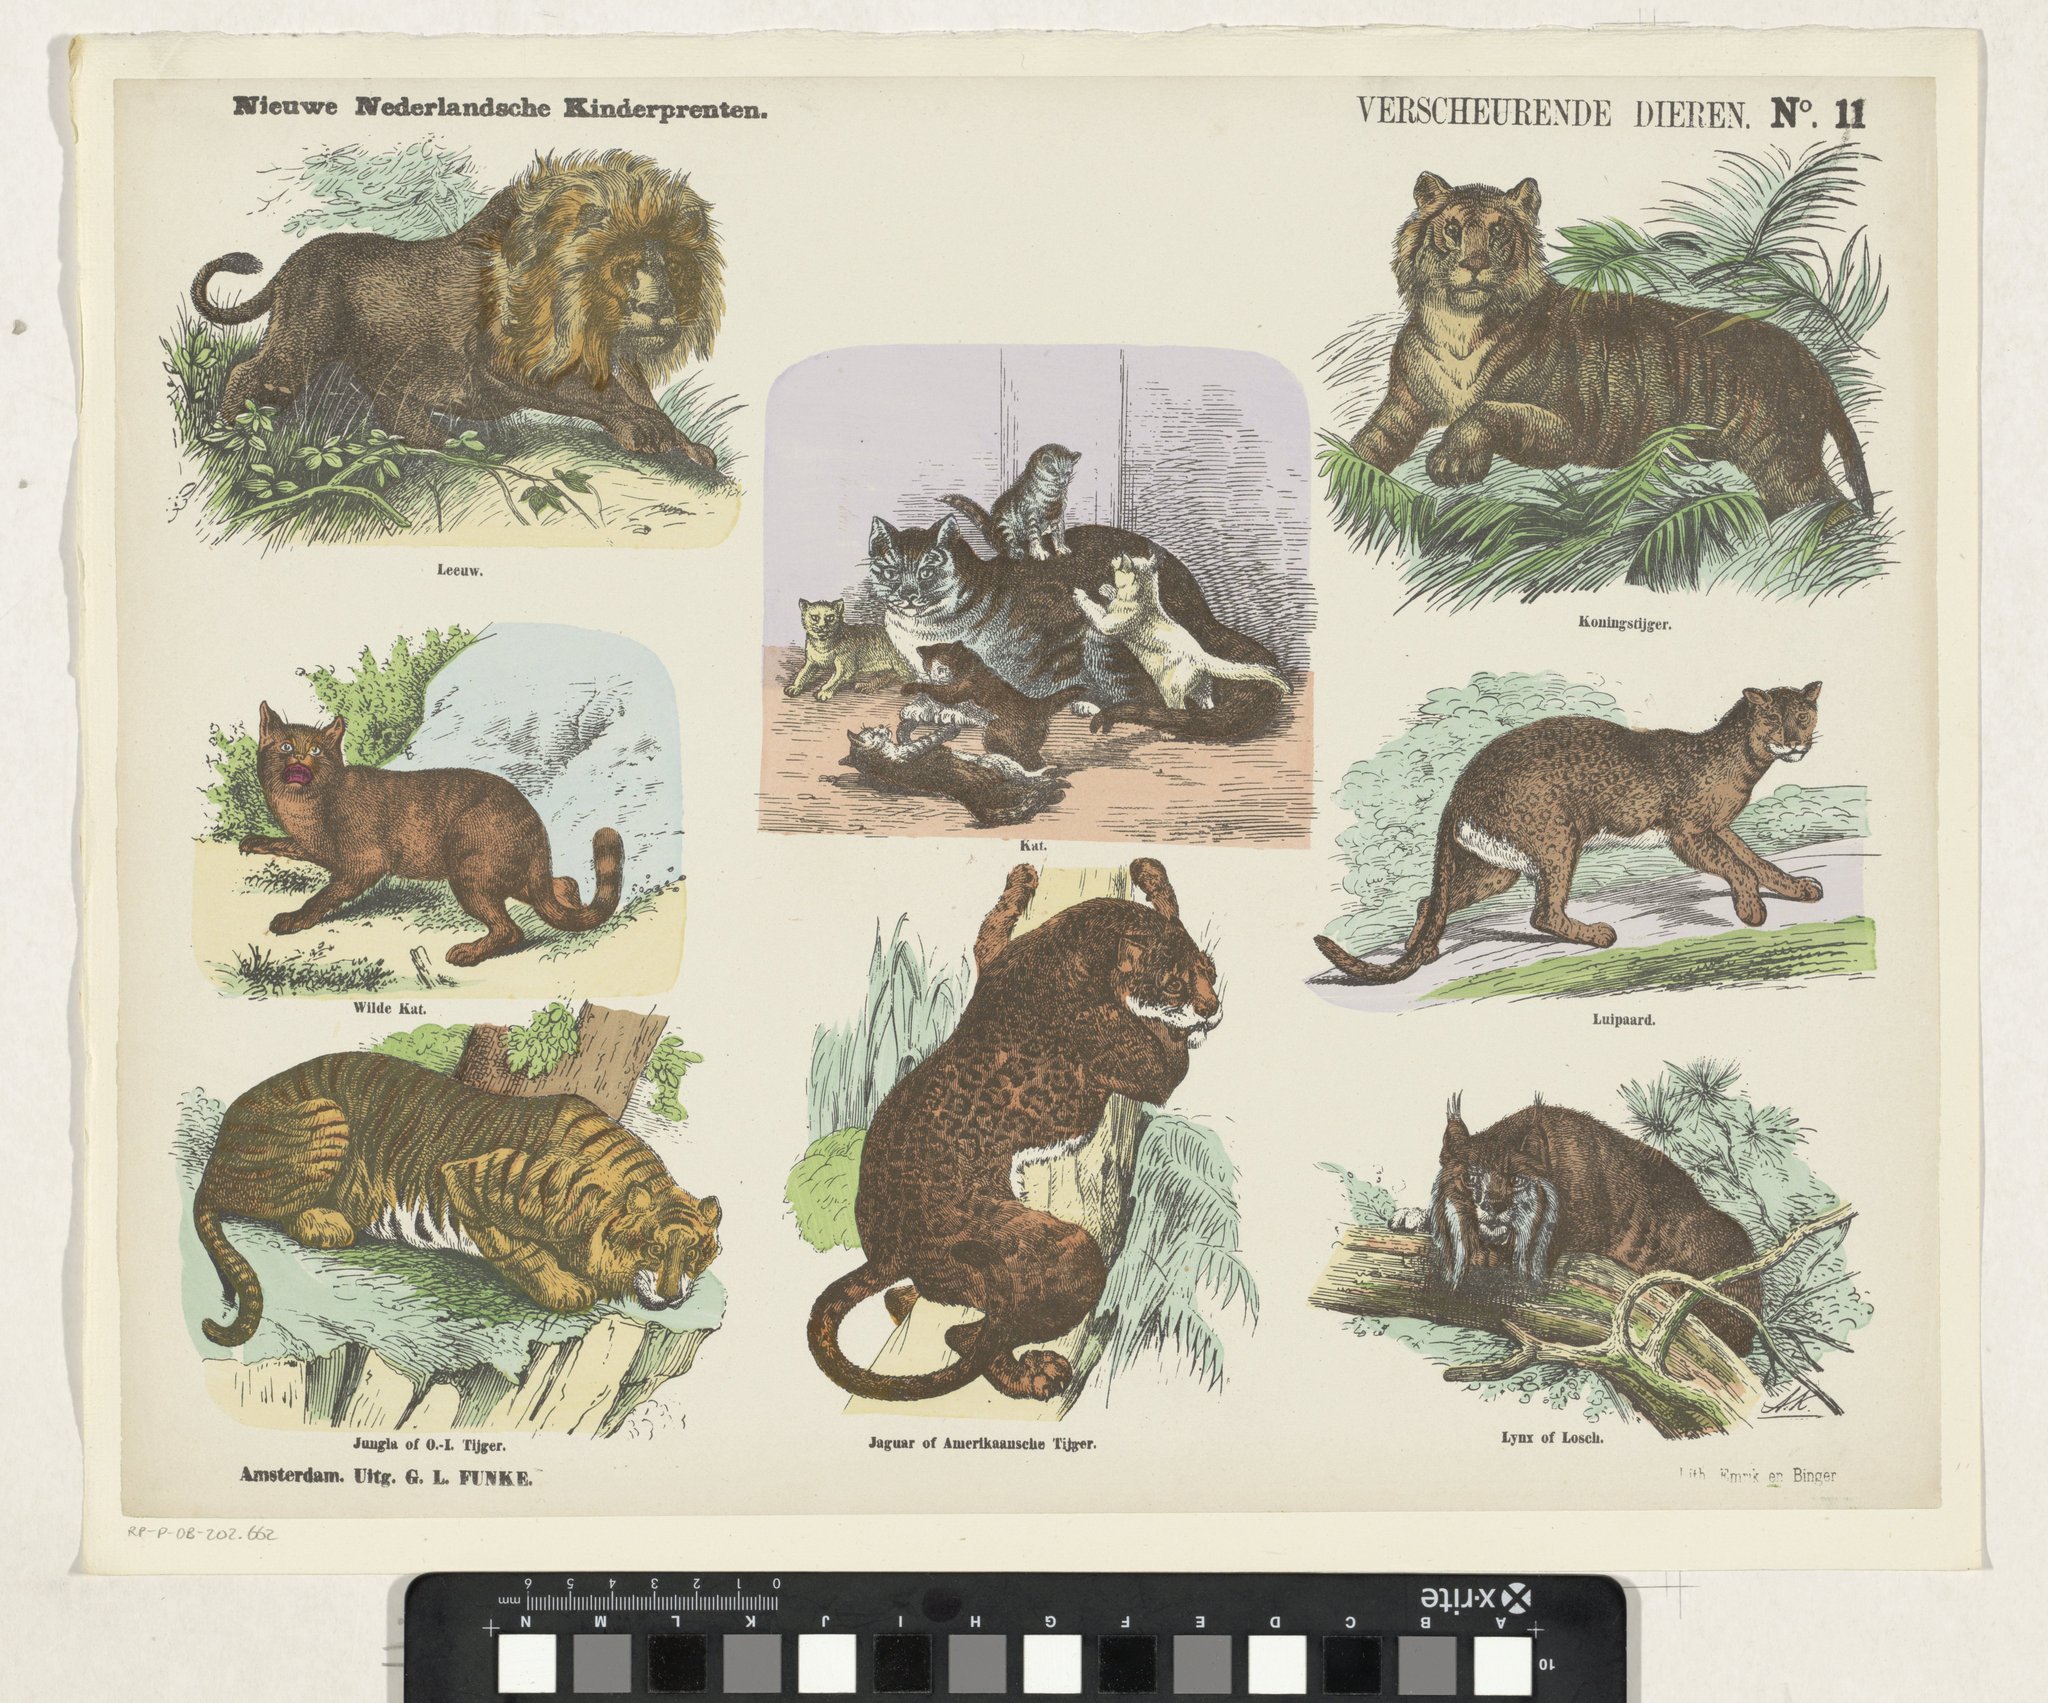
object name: popular print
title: Nieuwe Nederlandsche kinderprenten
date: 1865-1875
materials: paper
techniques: lithograph, letterpress printing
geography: haarlem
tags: beasts of prey, predatory animals: tiger, beasts of prey, predatory animals: leopard, beasts of prey, predatory animals, beasts of prey, predatory animals: lion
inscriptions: collector's mark: Lugt 2760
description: Blad met 8 voorstellingen van roofdieren (katachtigen), onder andere een leeuw, een tijger en een luipaard. Onder elke afbeelding een onderschrift. Genummerd rechtsboven: No. 11.